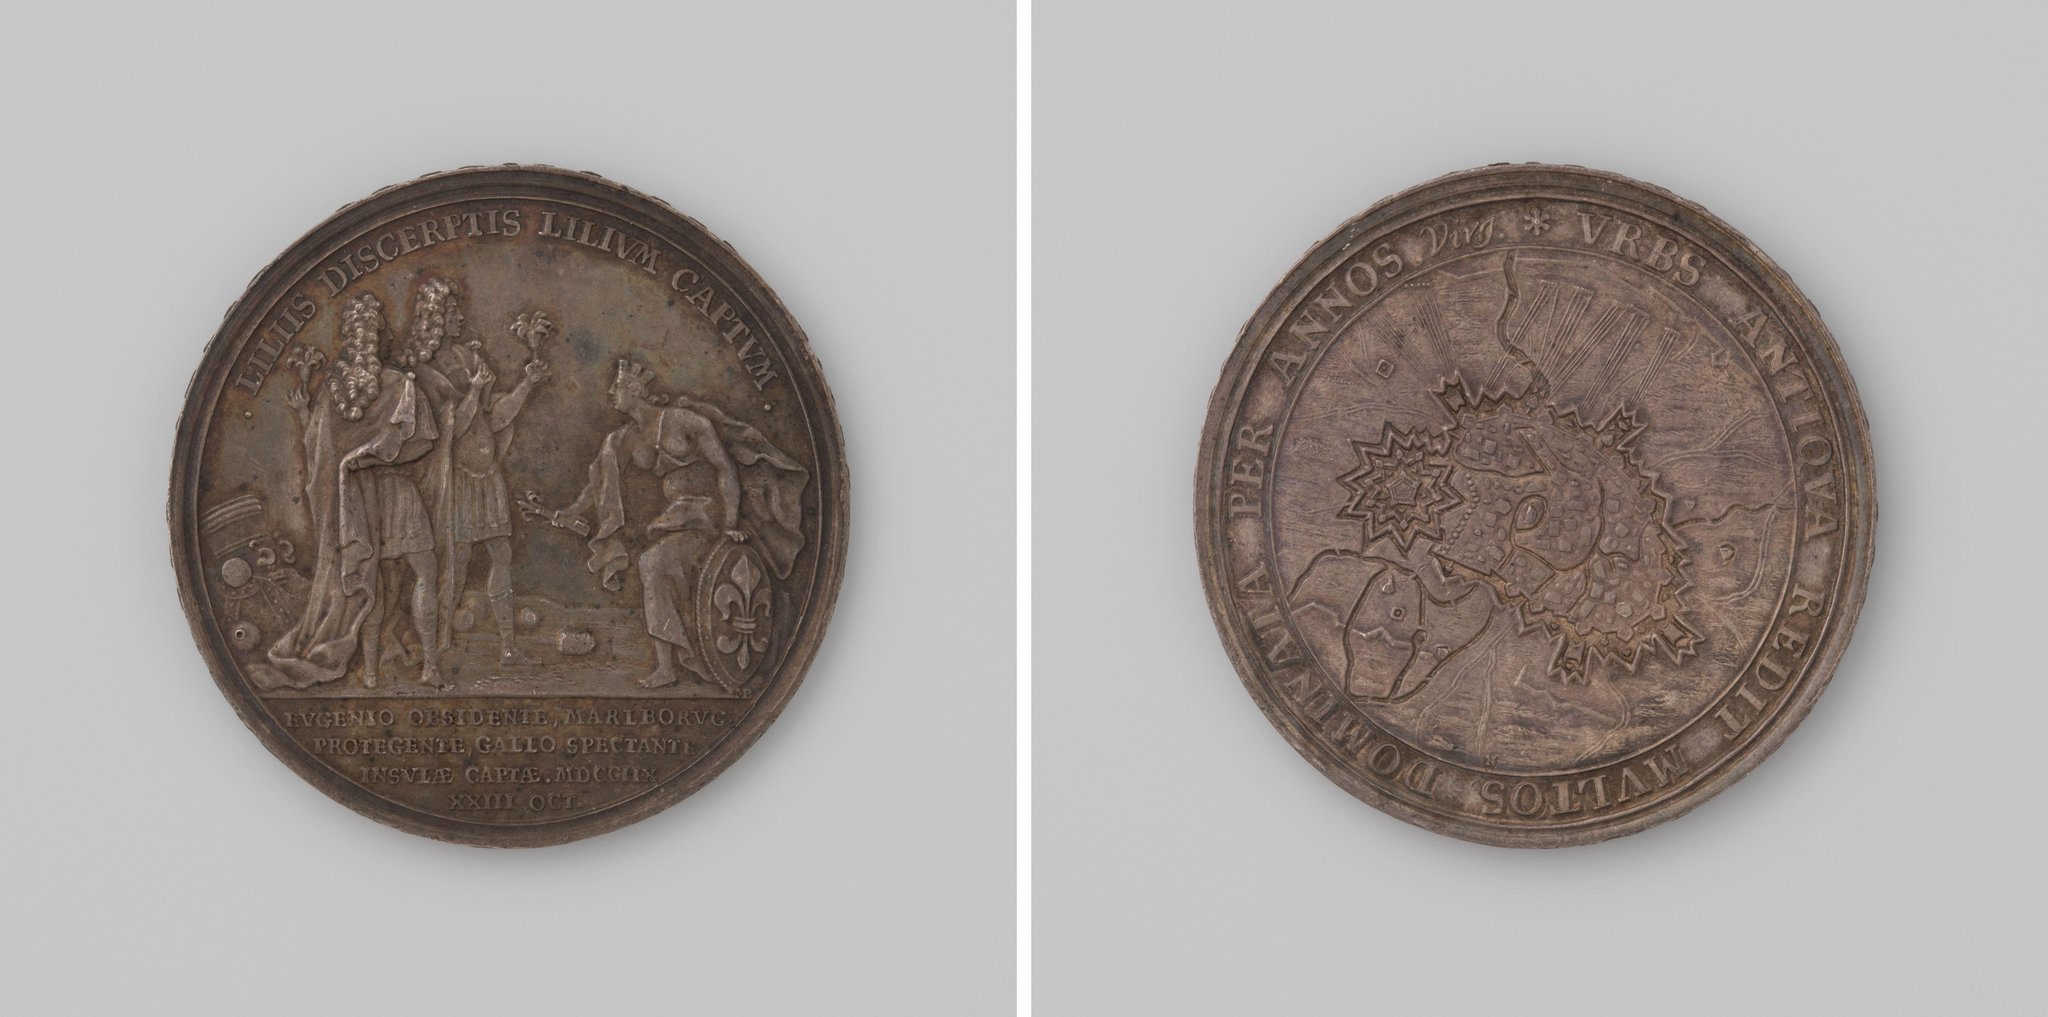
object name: history medal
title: Rijssel door de bondgenoten ingenomen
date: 1708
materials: silver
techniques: striking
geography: nuremberg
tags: paris, vienna, eugenius van savoye, john churchill (1e hertog van marlborough), lille